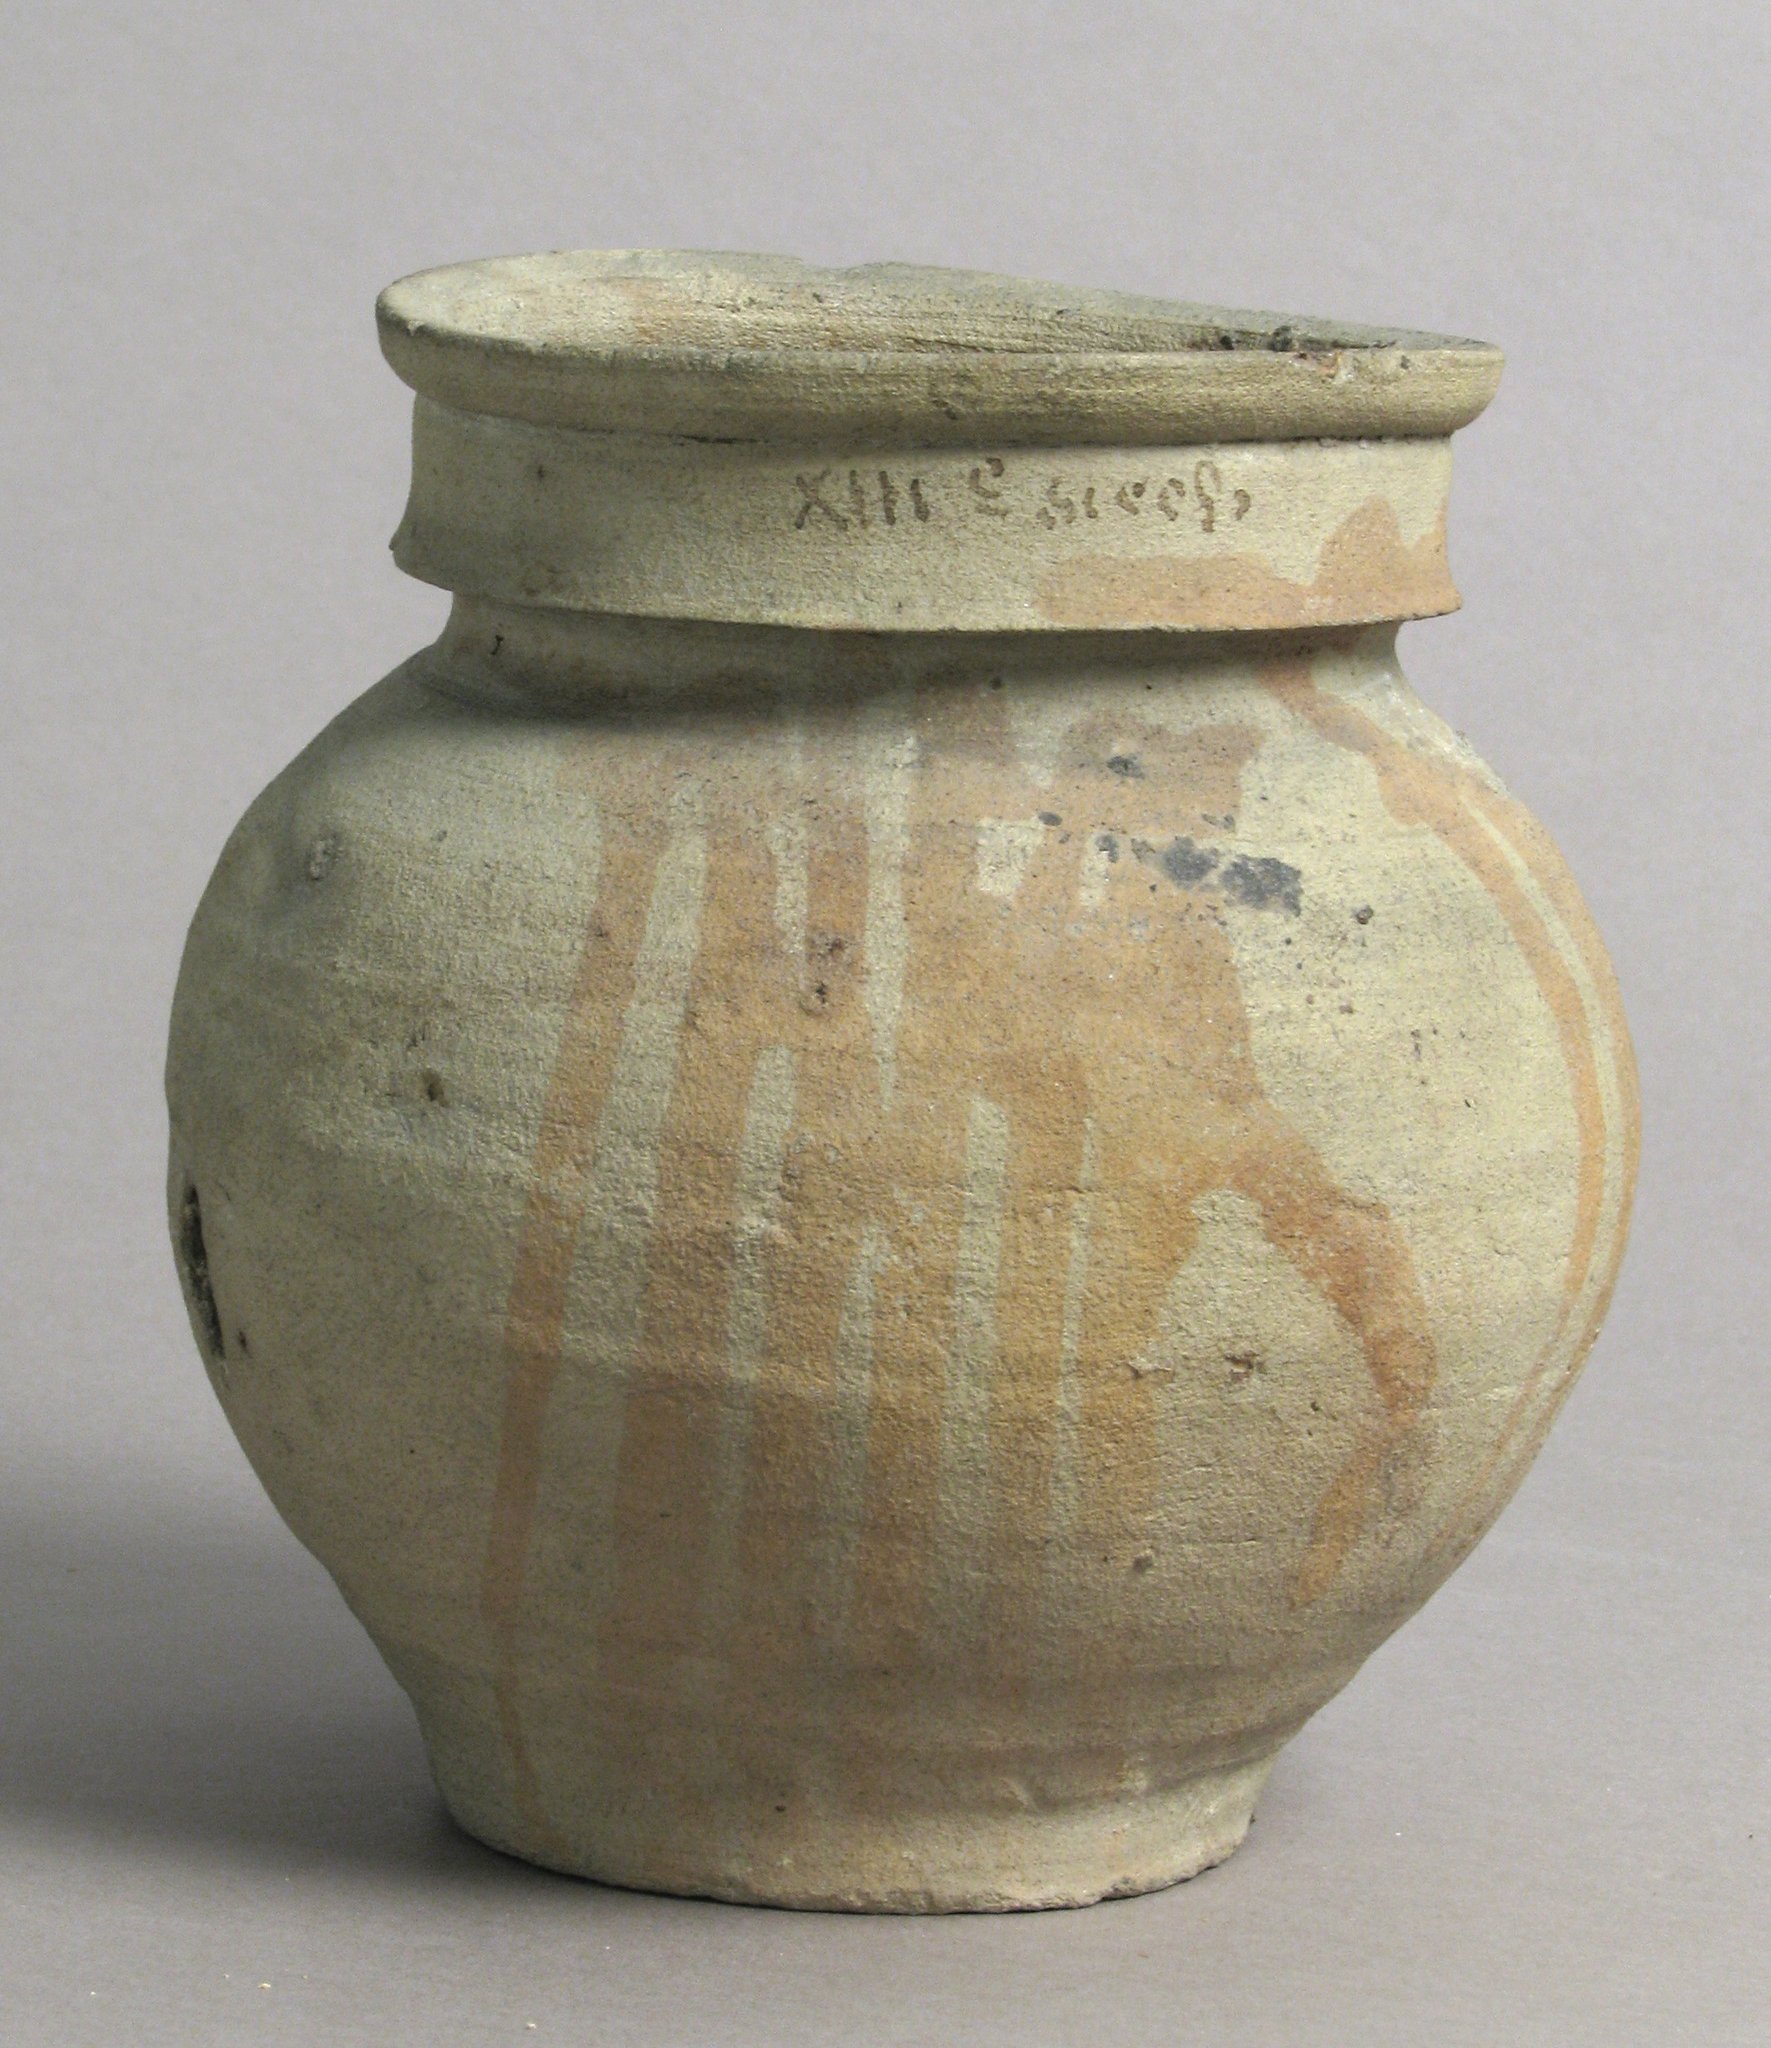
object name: jar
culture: french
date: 1201-1400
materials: earthenware